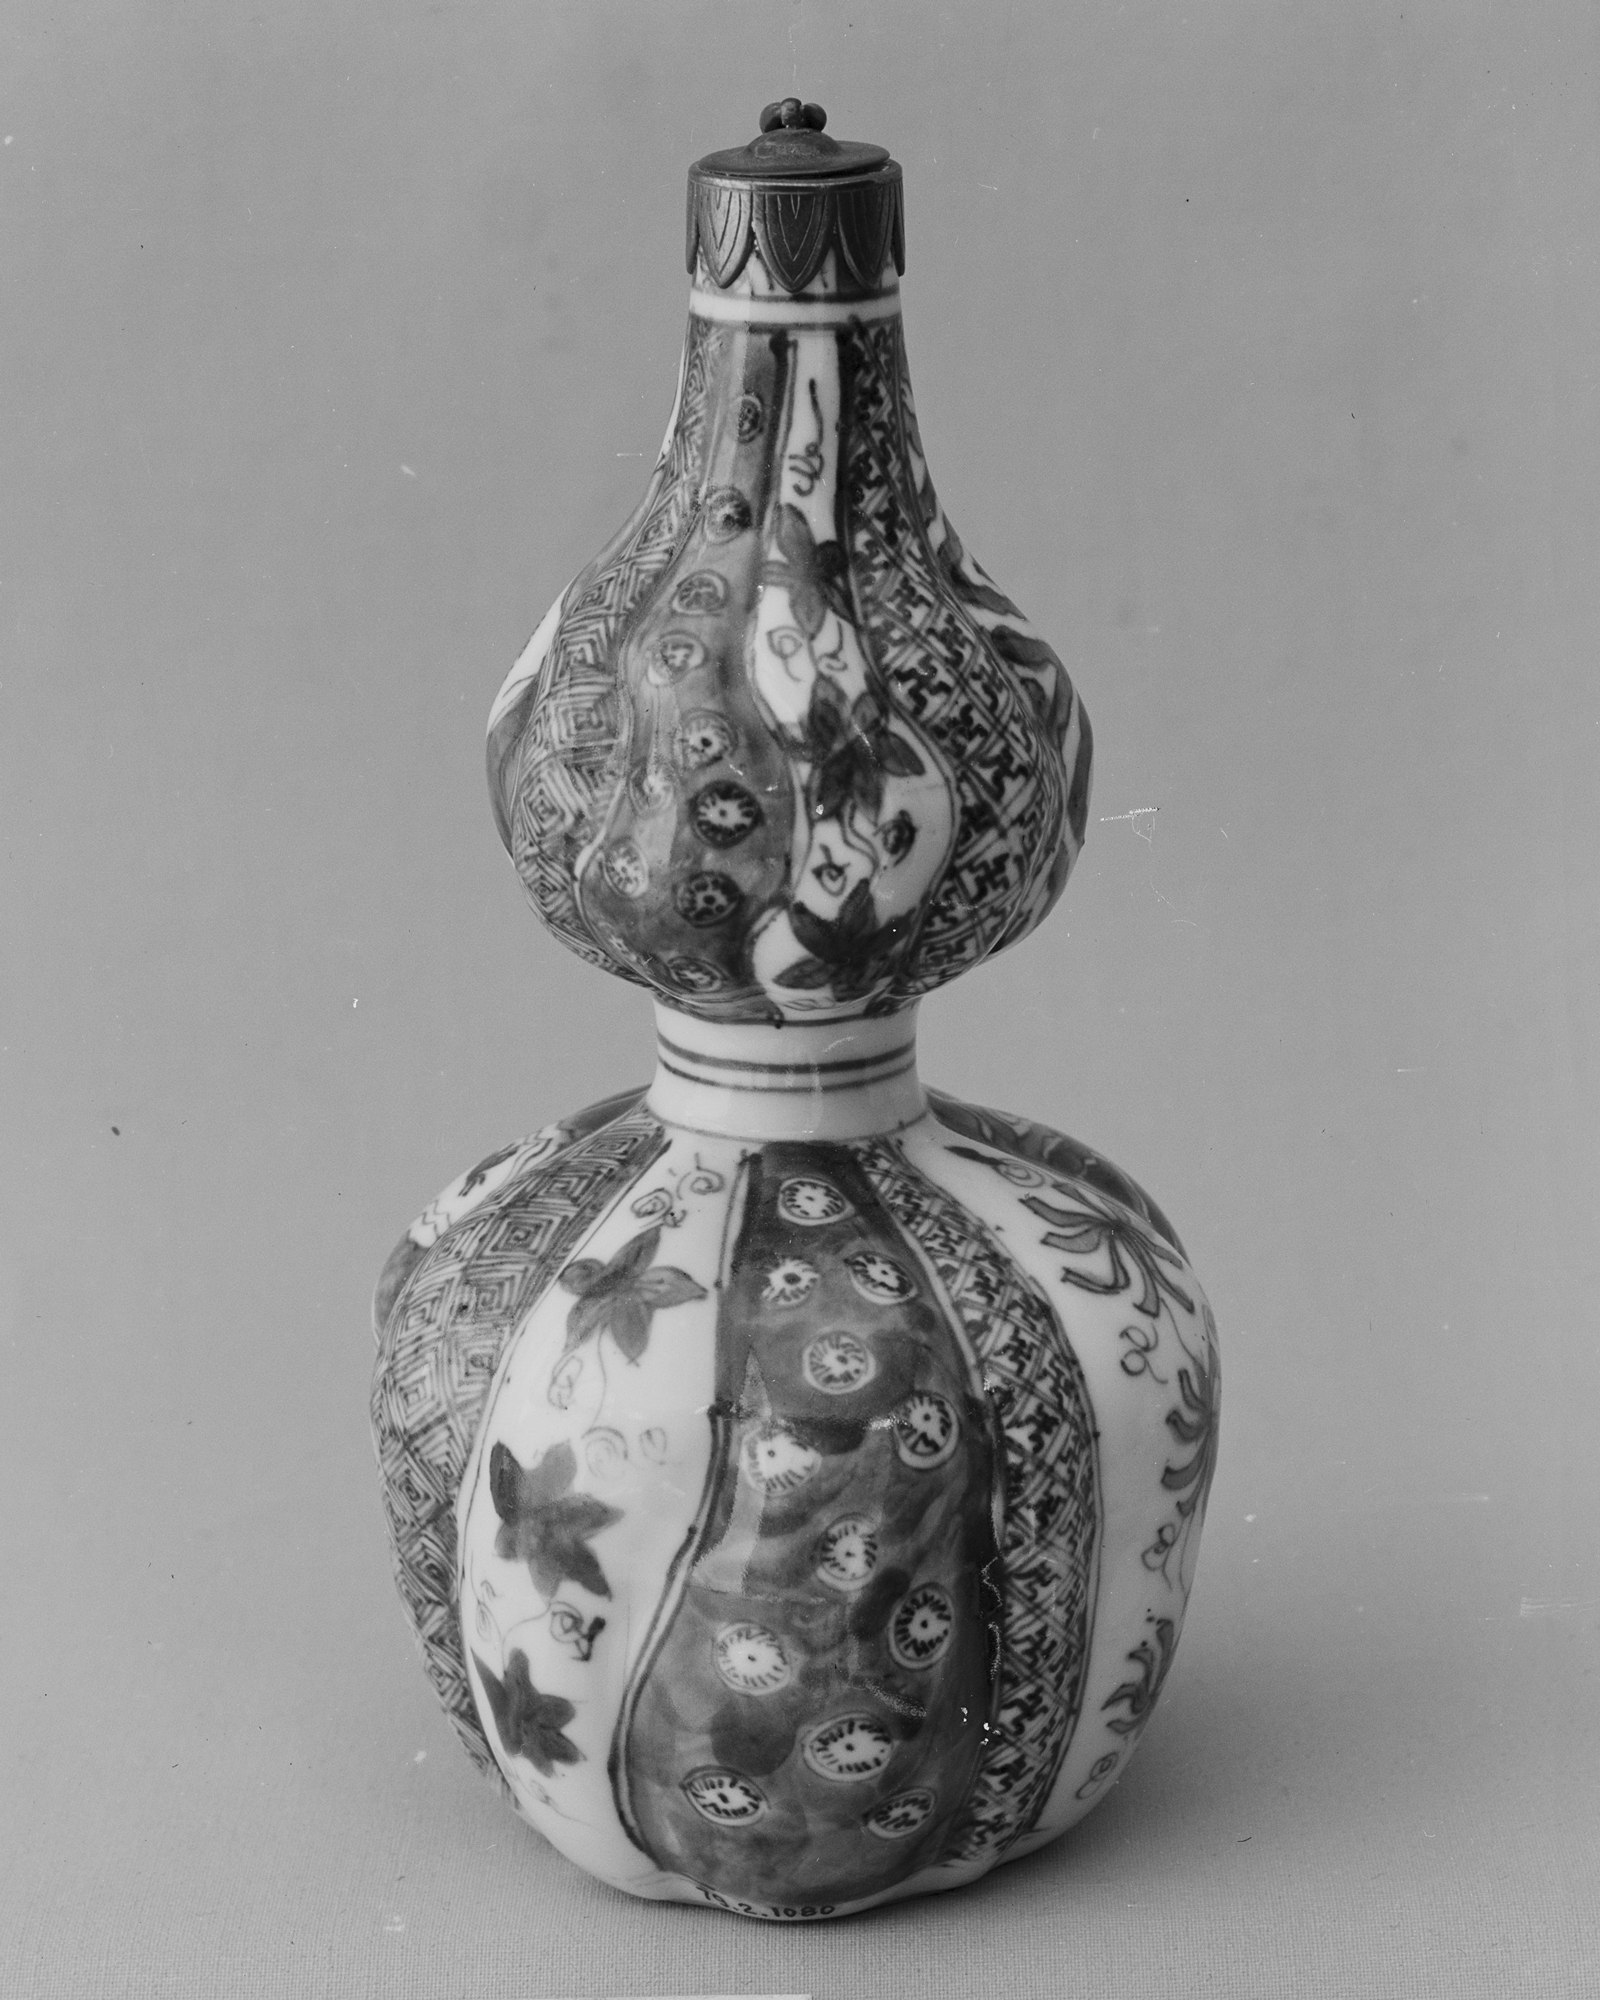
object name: bottle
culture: chinese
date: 1601-1700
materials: cobalt, glaze, porcelain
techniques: painting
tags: flowers